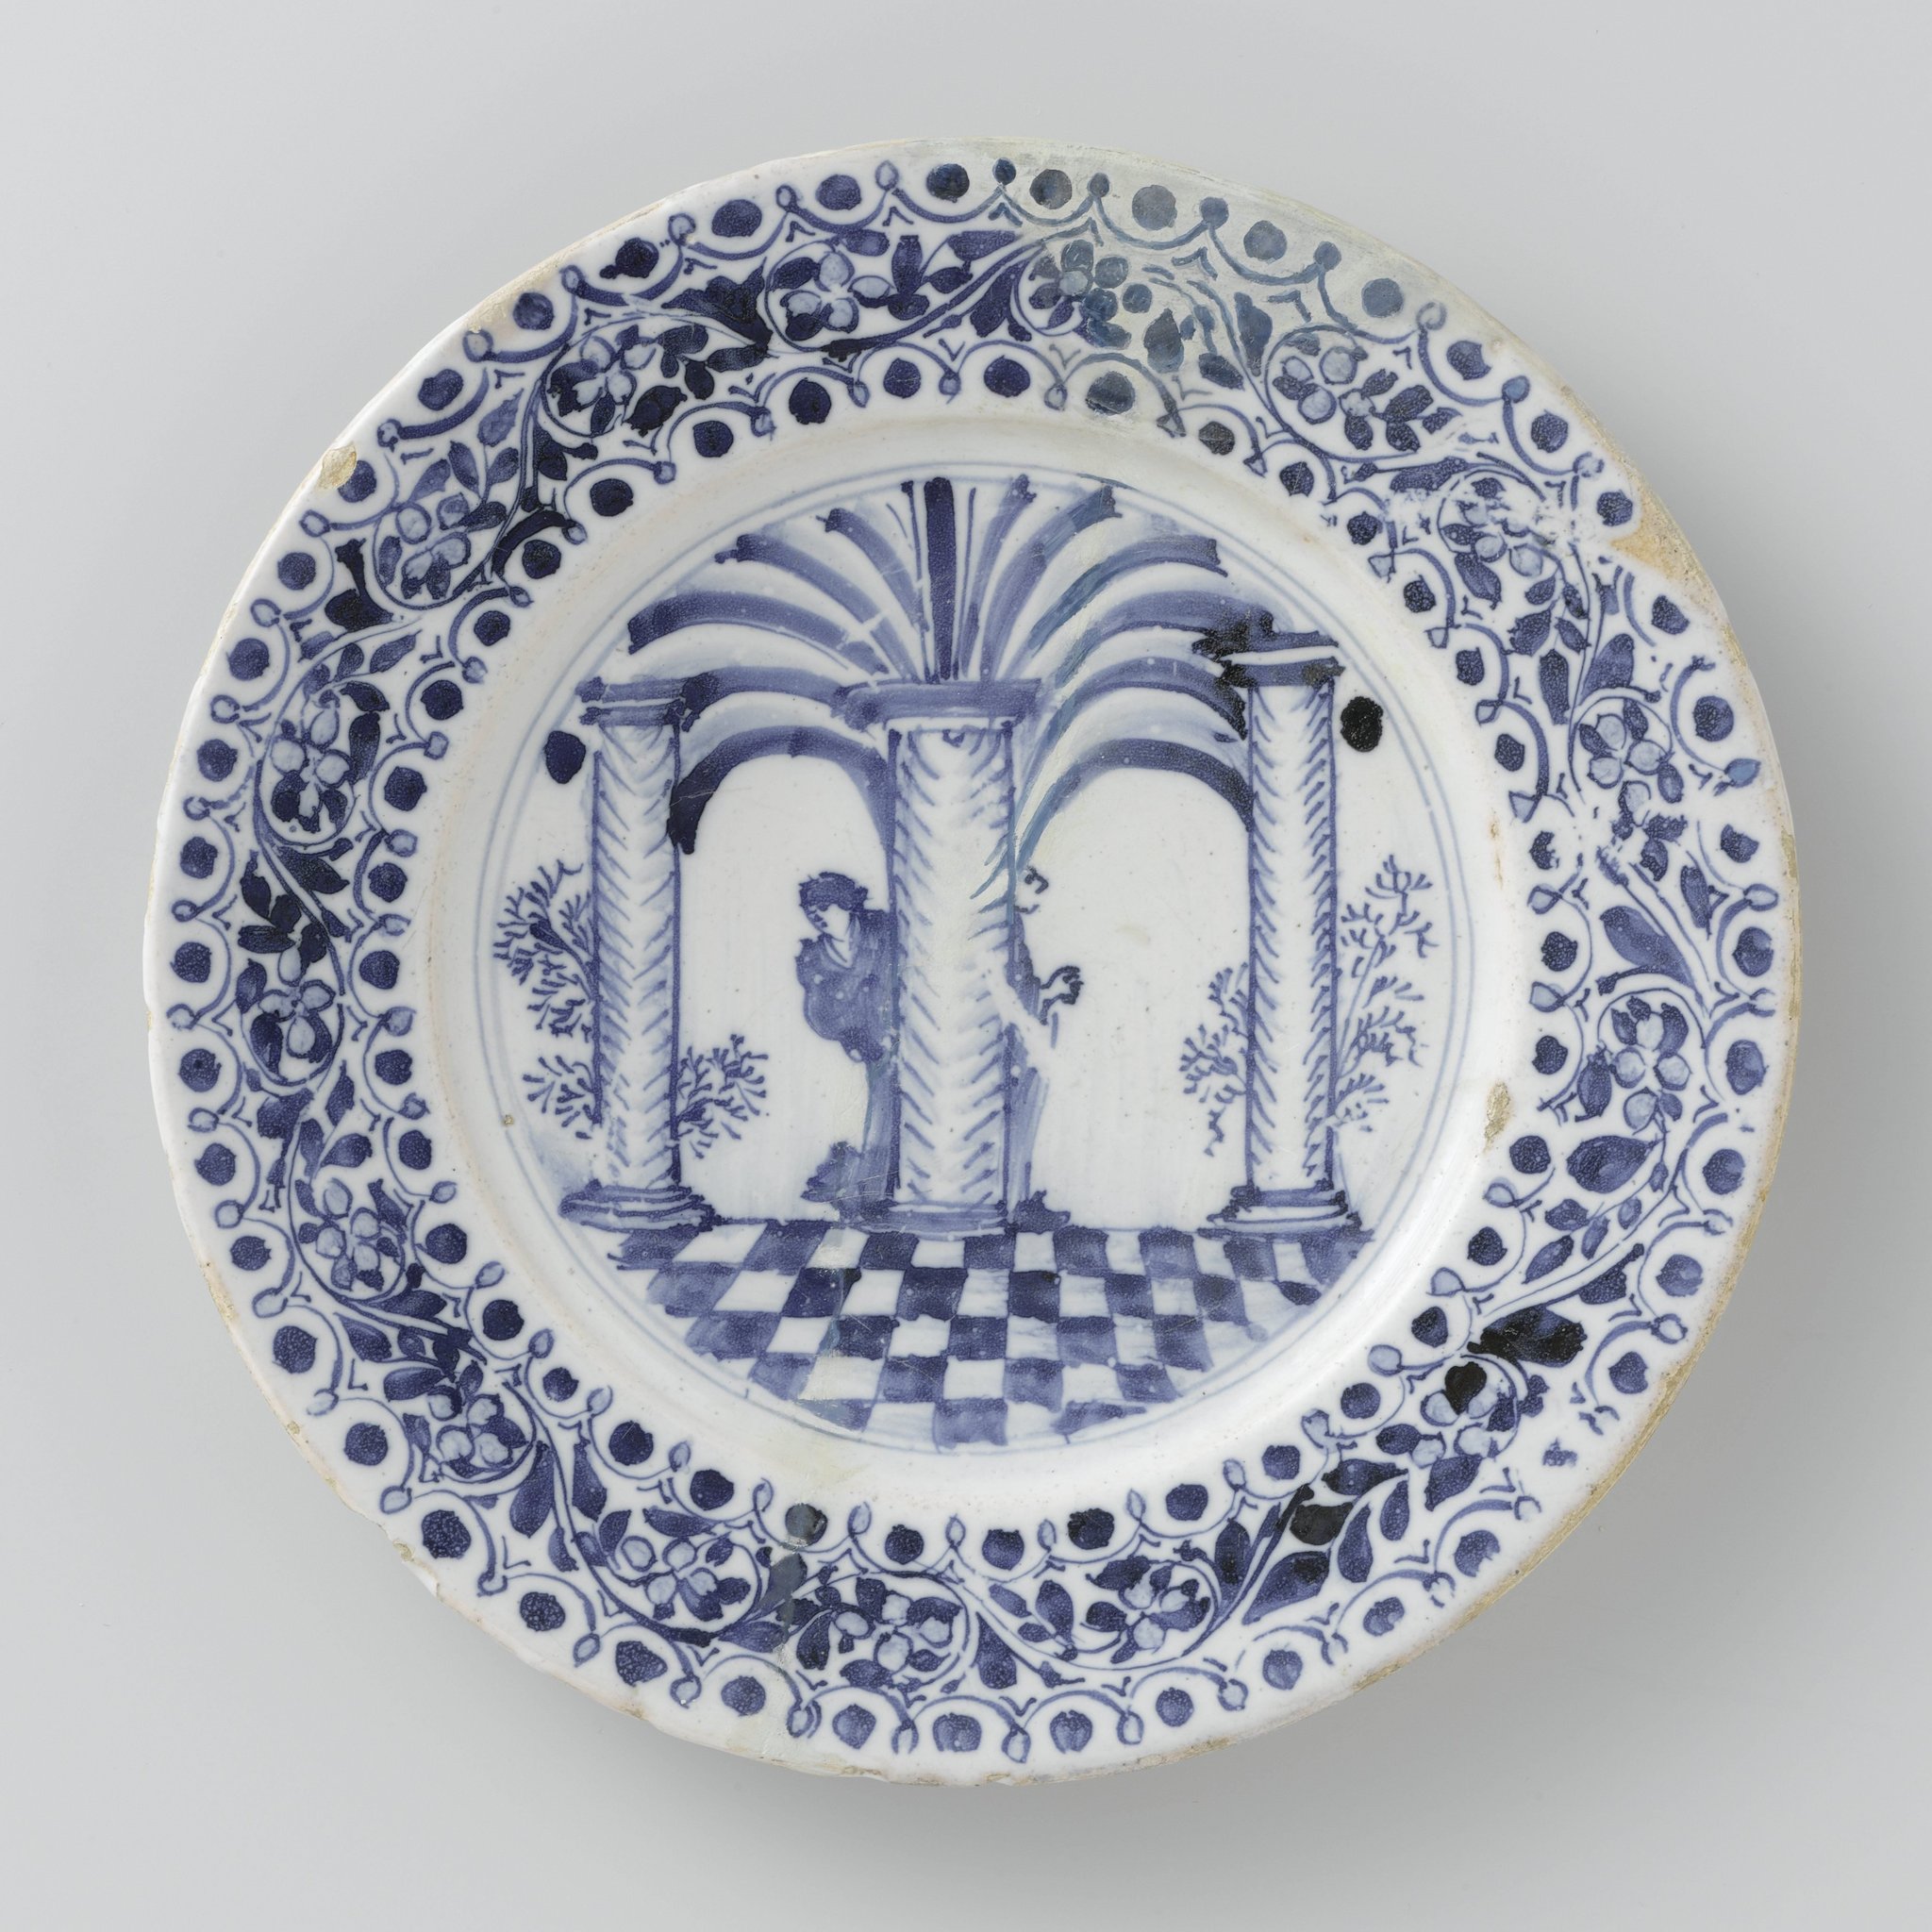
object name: plate dish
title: Bord, beschilderd met twee Chinezen in een gebouw met zuil.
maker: Anonymous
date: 1650-1670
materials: earthenware, glaze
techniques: painted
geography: delft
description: Rond bord van blauw beschilderde faience. Op het plat zijn twee figuren (Chinezen) bij een zuil in een gebouw geschilderd, de rand is rijk versierd oa. met een bloemenrank. Het bord is een bodemvondst.